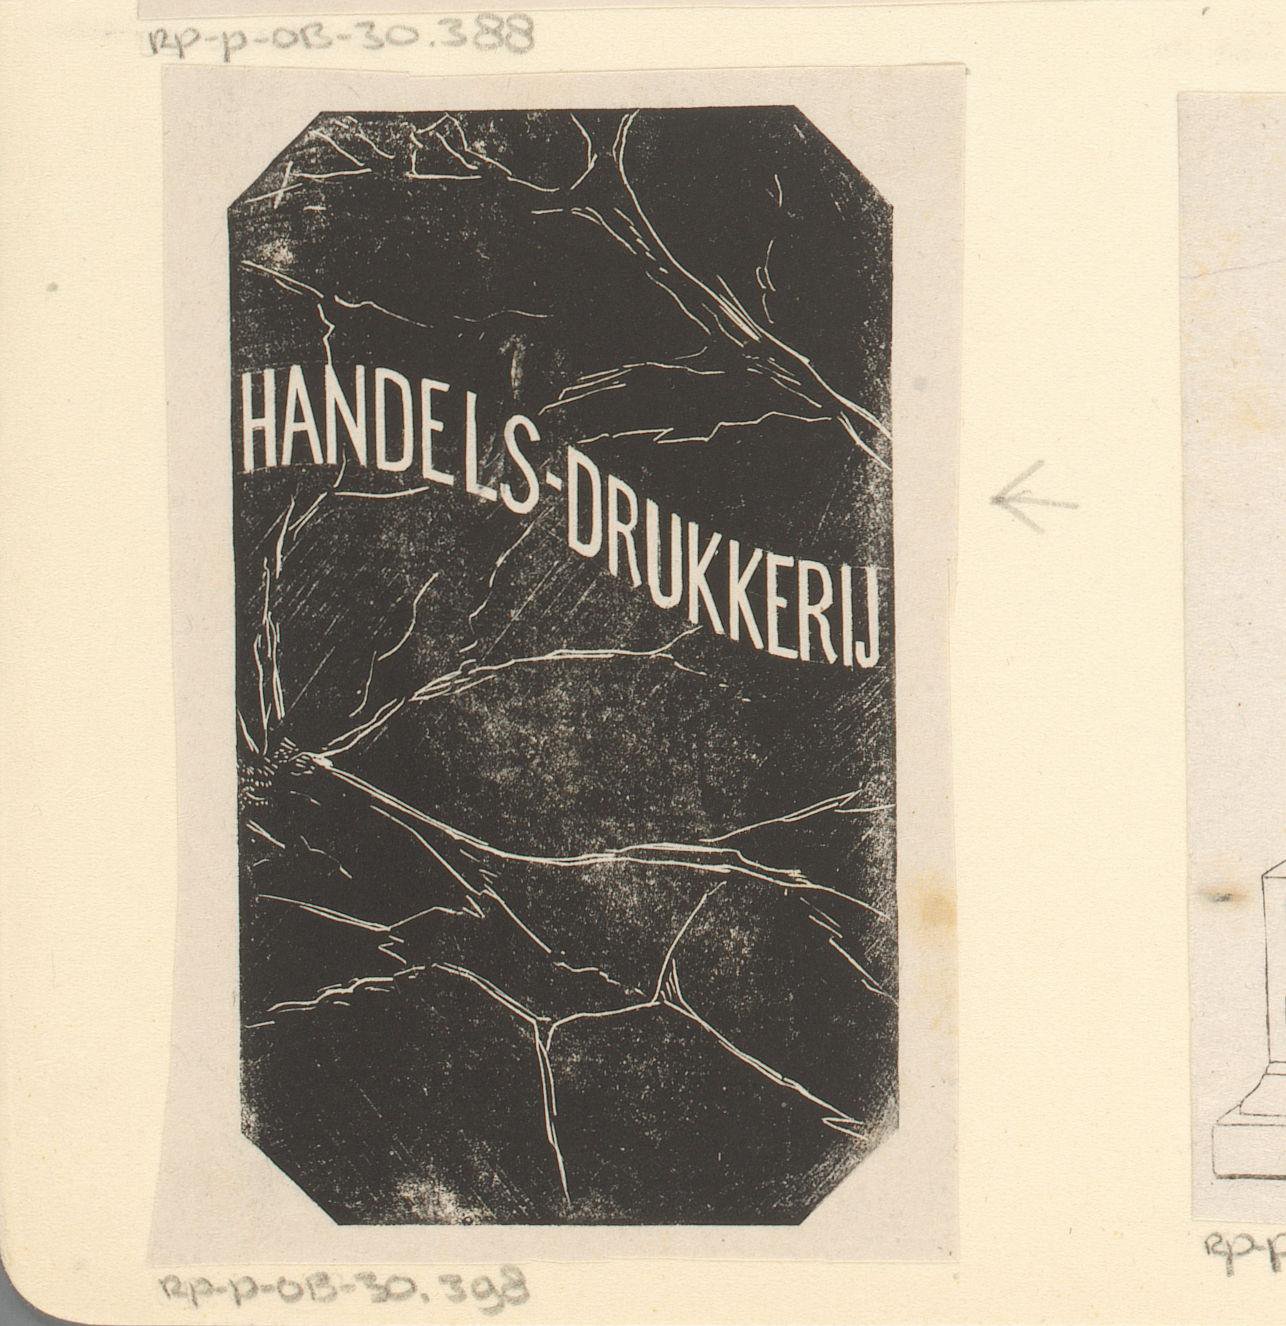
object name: print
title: Vignet van een handelsdrukkerij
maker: isaac weissenbruch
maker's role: print maker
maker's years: 1826-1912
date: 1836-1912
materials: paper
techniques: engraving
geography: netherlands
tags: vignette